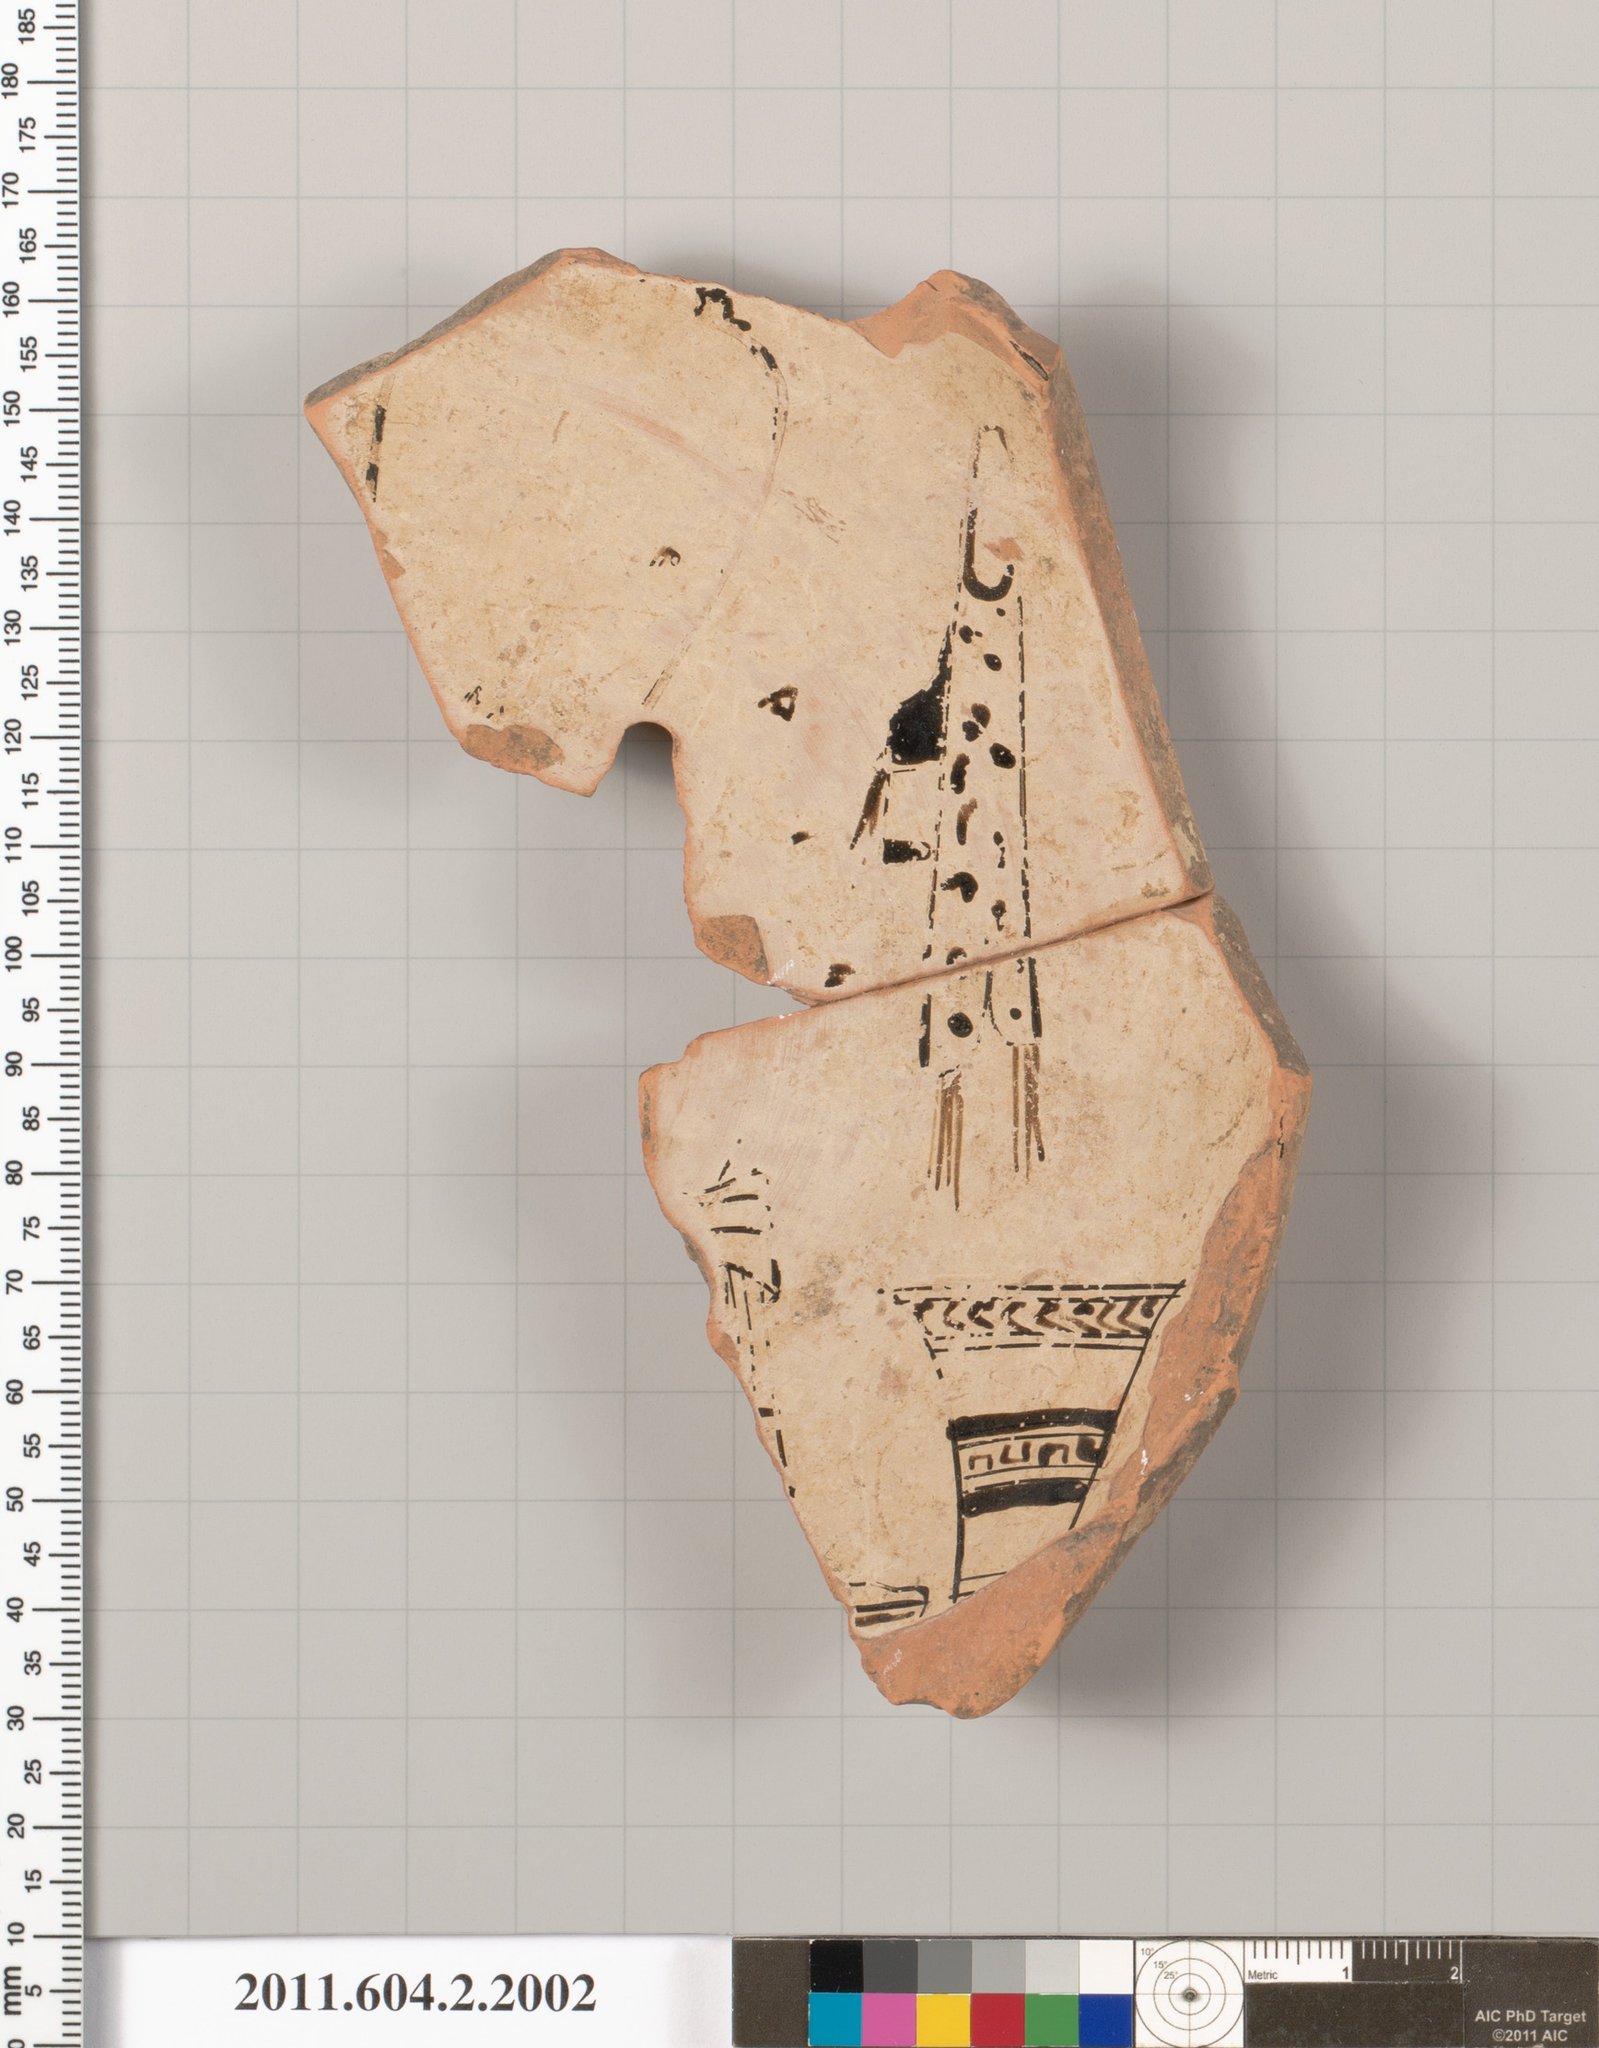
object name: plate fragment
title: Terracotta fragment of a plate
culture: greek, attic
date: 470 BCE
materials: terracotta